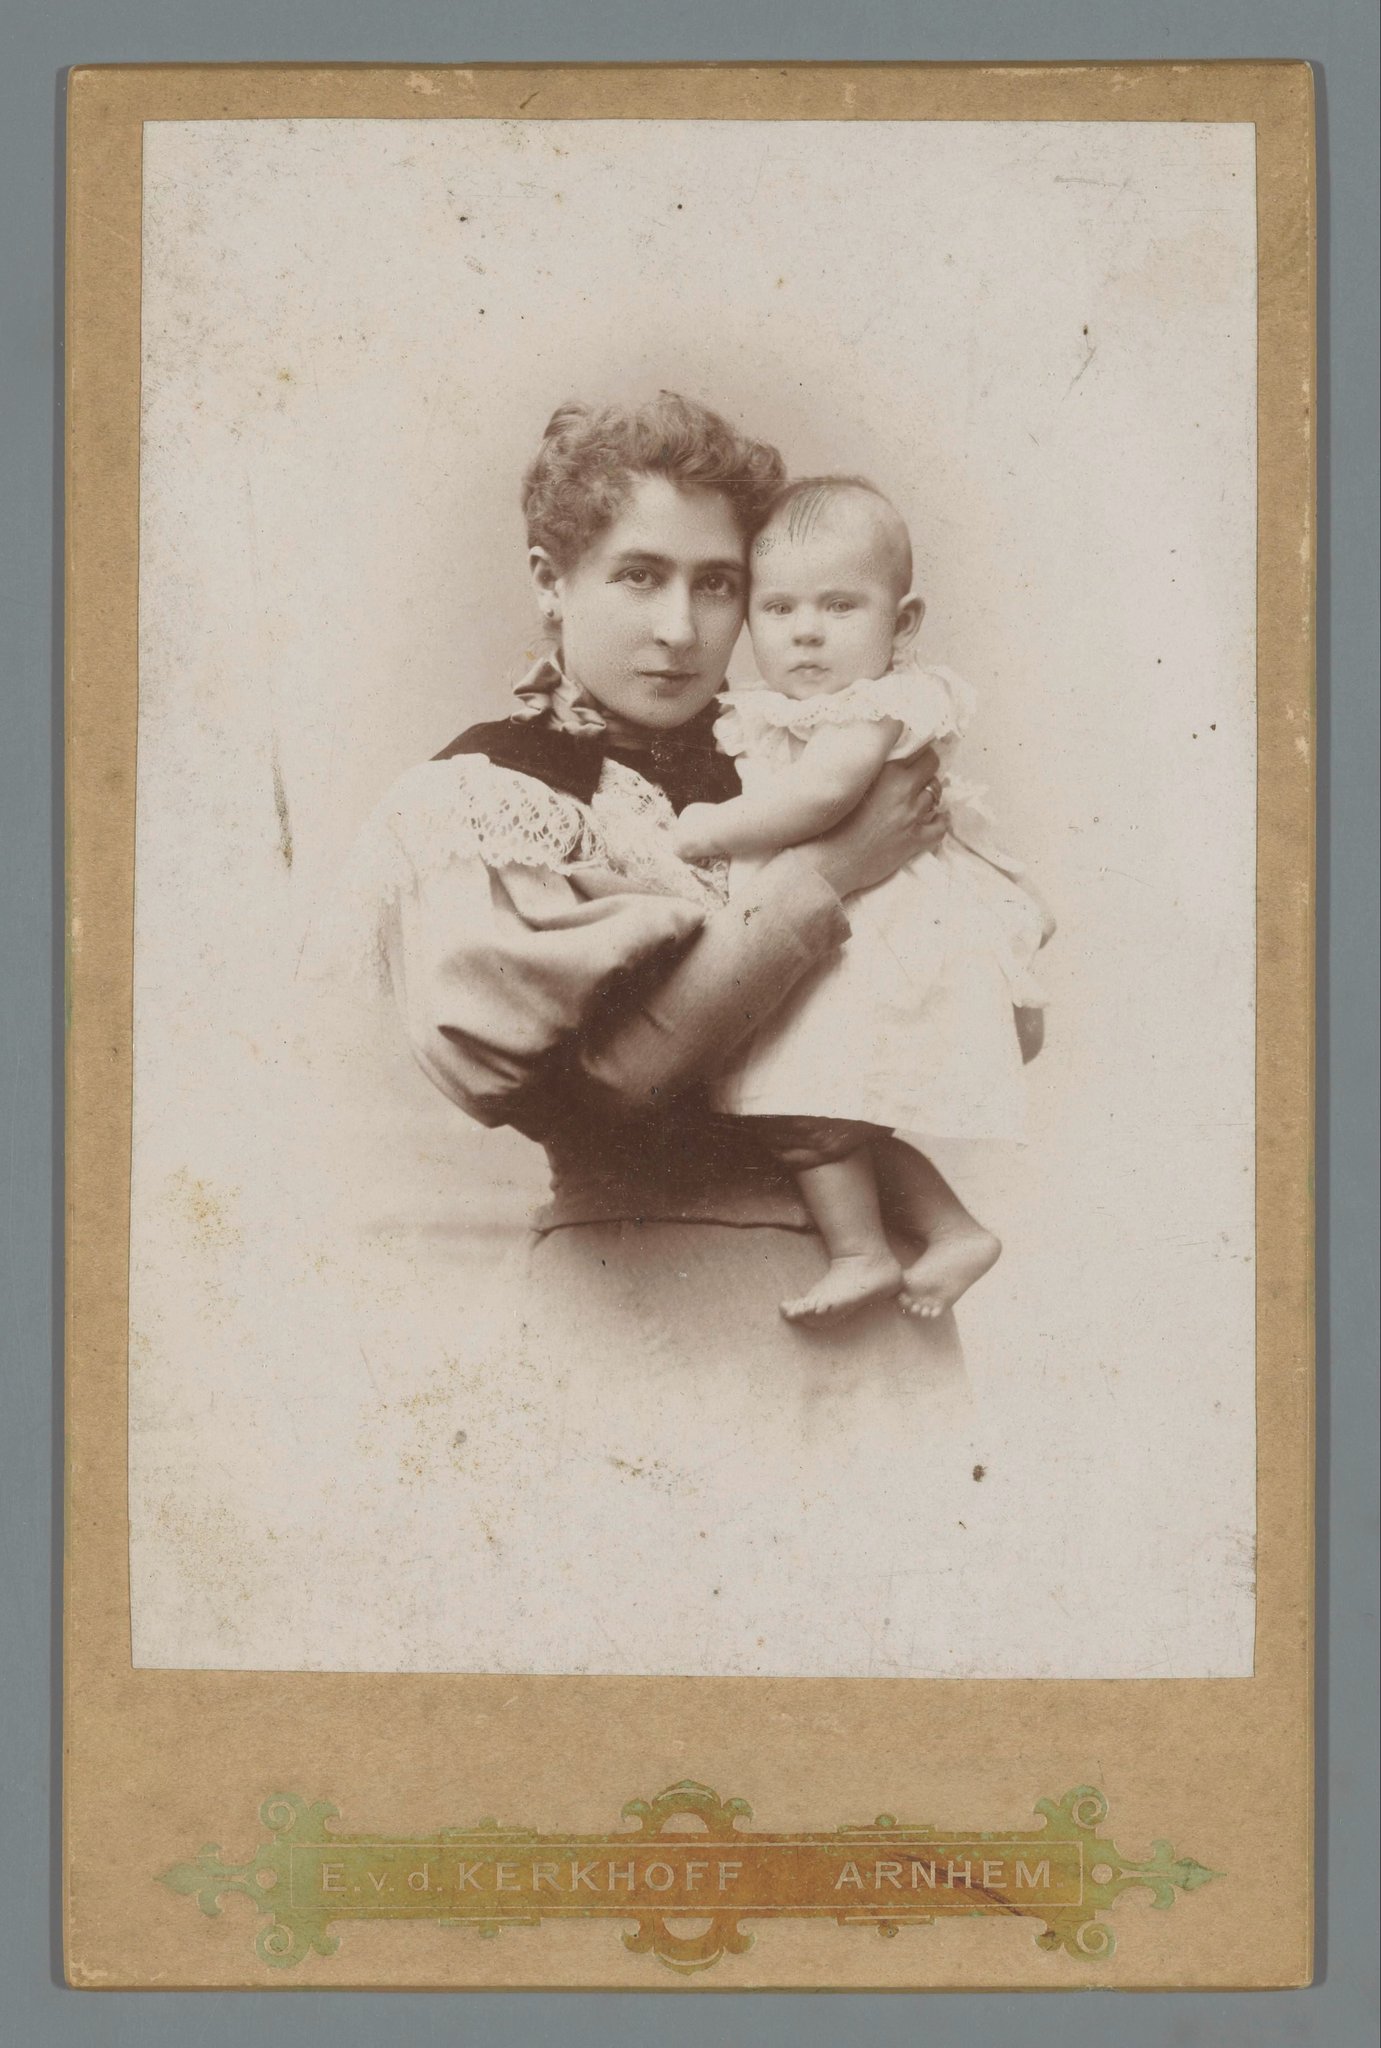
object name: cabinet photograph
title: Portret van een onbekende vrouw met een baby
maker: e. v.d. kerkhoff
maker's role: fotograaf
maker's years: 1861-1943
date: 1895-1908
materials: cardboard, photographic support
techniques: collodion silver print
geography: arnhem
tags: adult woman, infant, baby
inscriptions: name: ‘Atelier E. v.d. Kerkhoff Arnhem Ridderstraat No. 27 (...)’